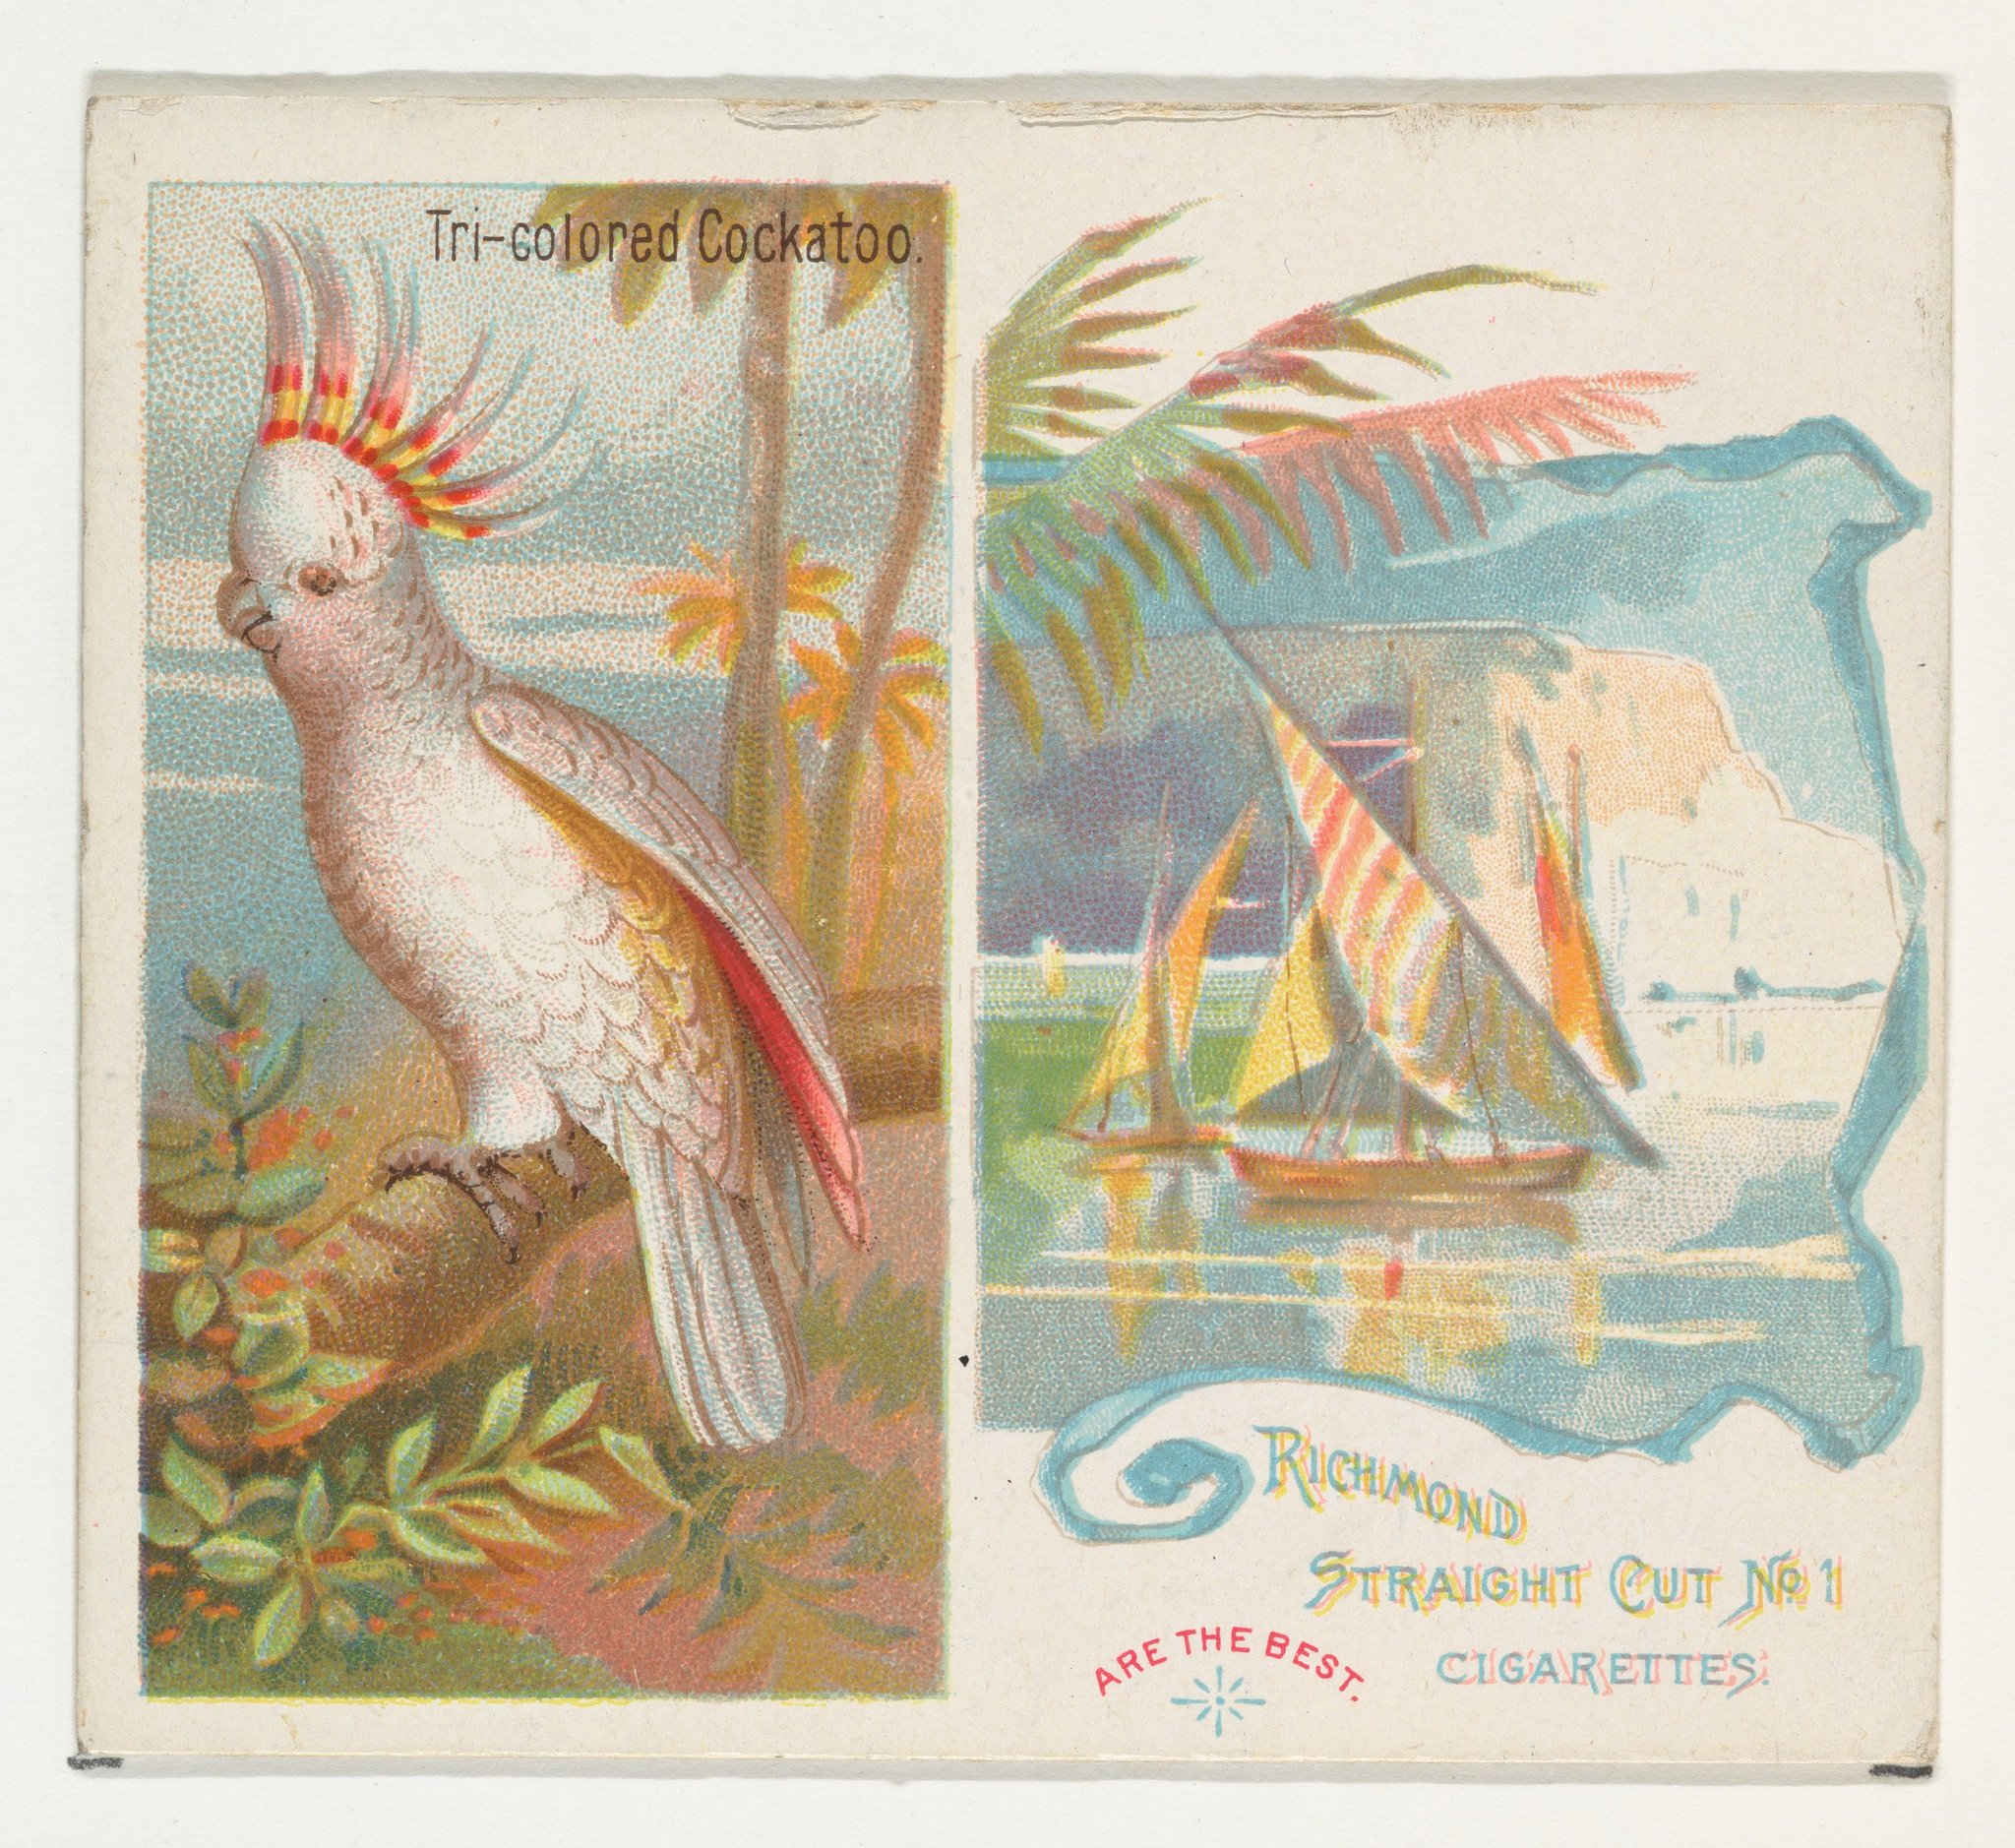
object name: print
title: Tri-colored Cockatoo, from Birds of the Tropics series (N38) for Allen & Ginter Cigarettes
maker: allen & ginter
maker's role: publisher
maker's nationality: american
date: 1889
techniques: color lithograph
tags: birds,boats